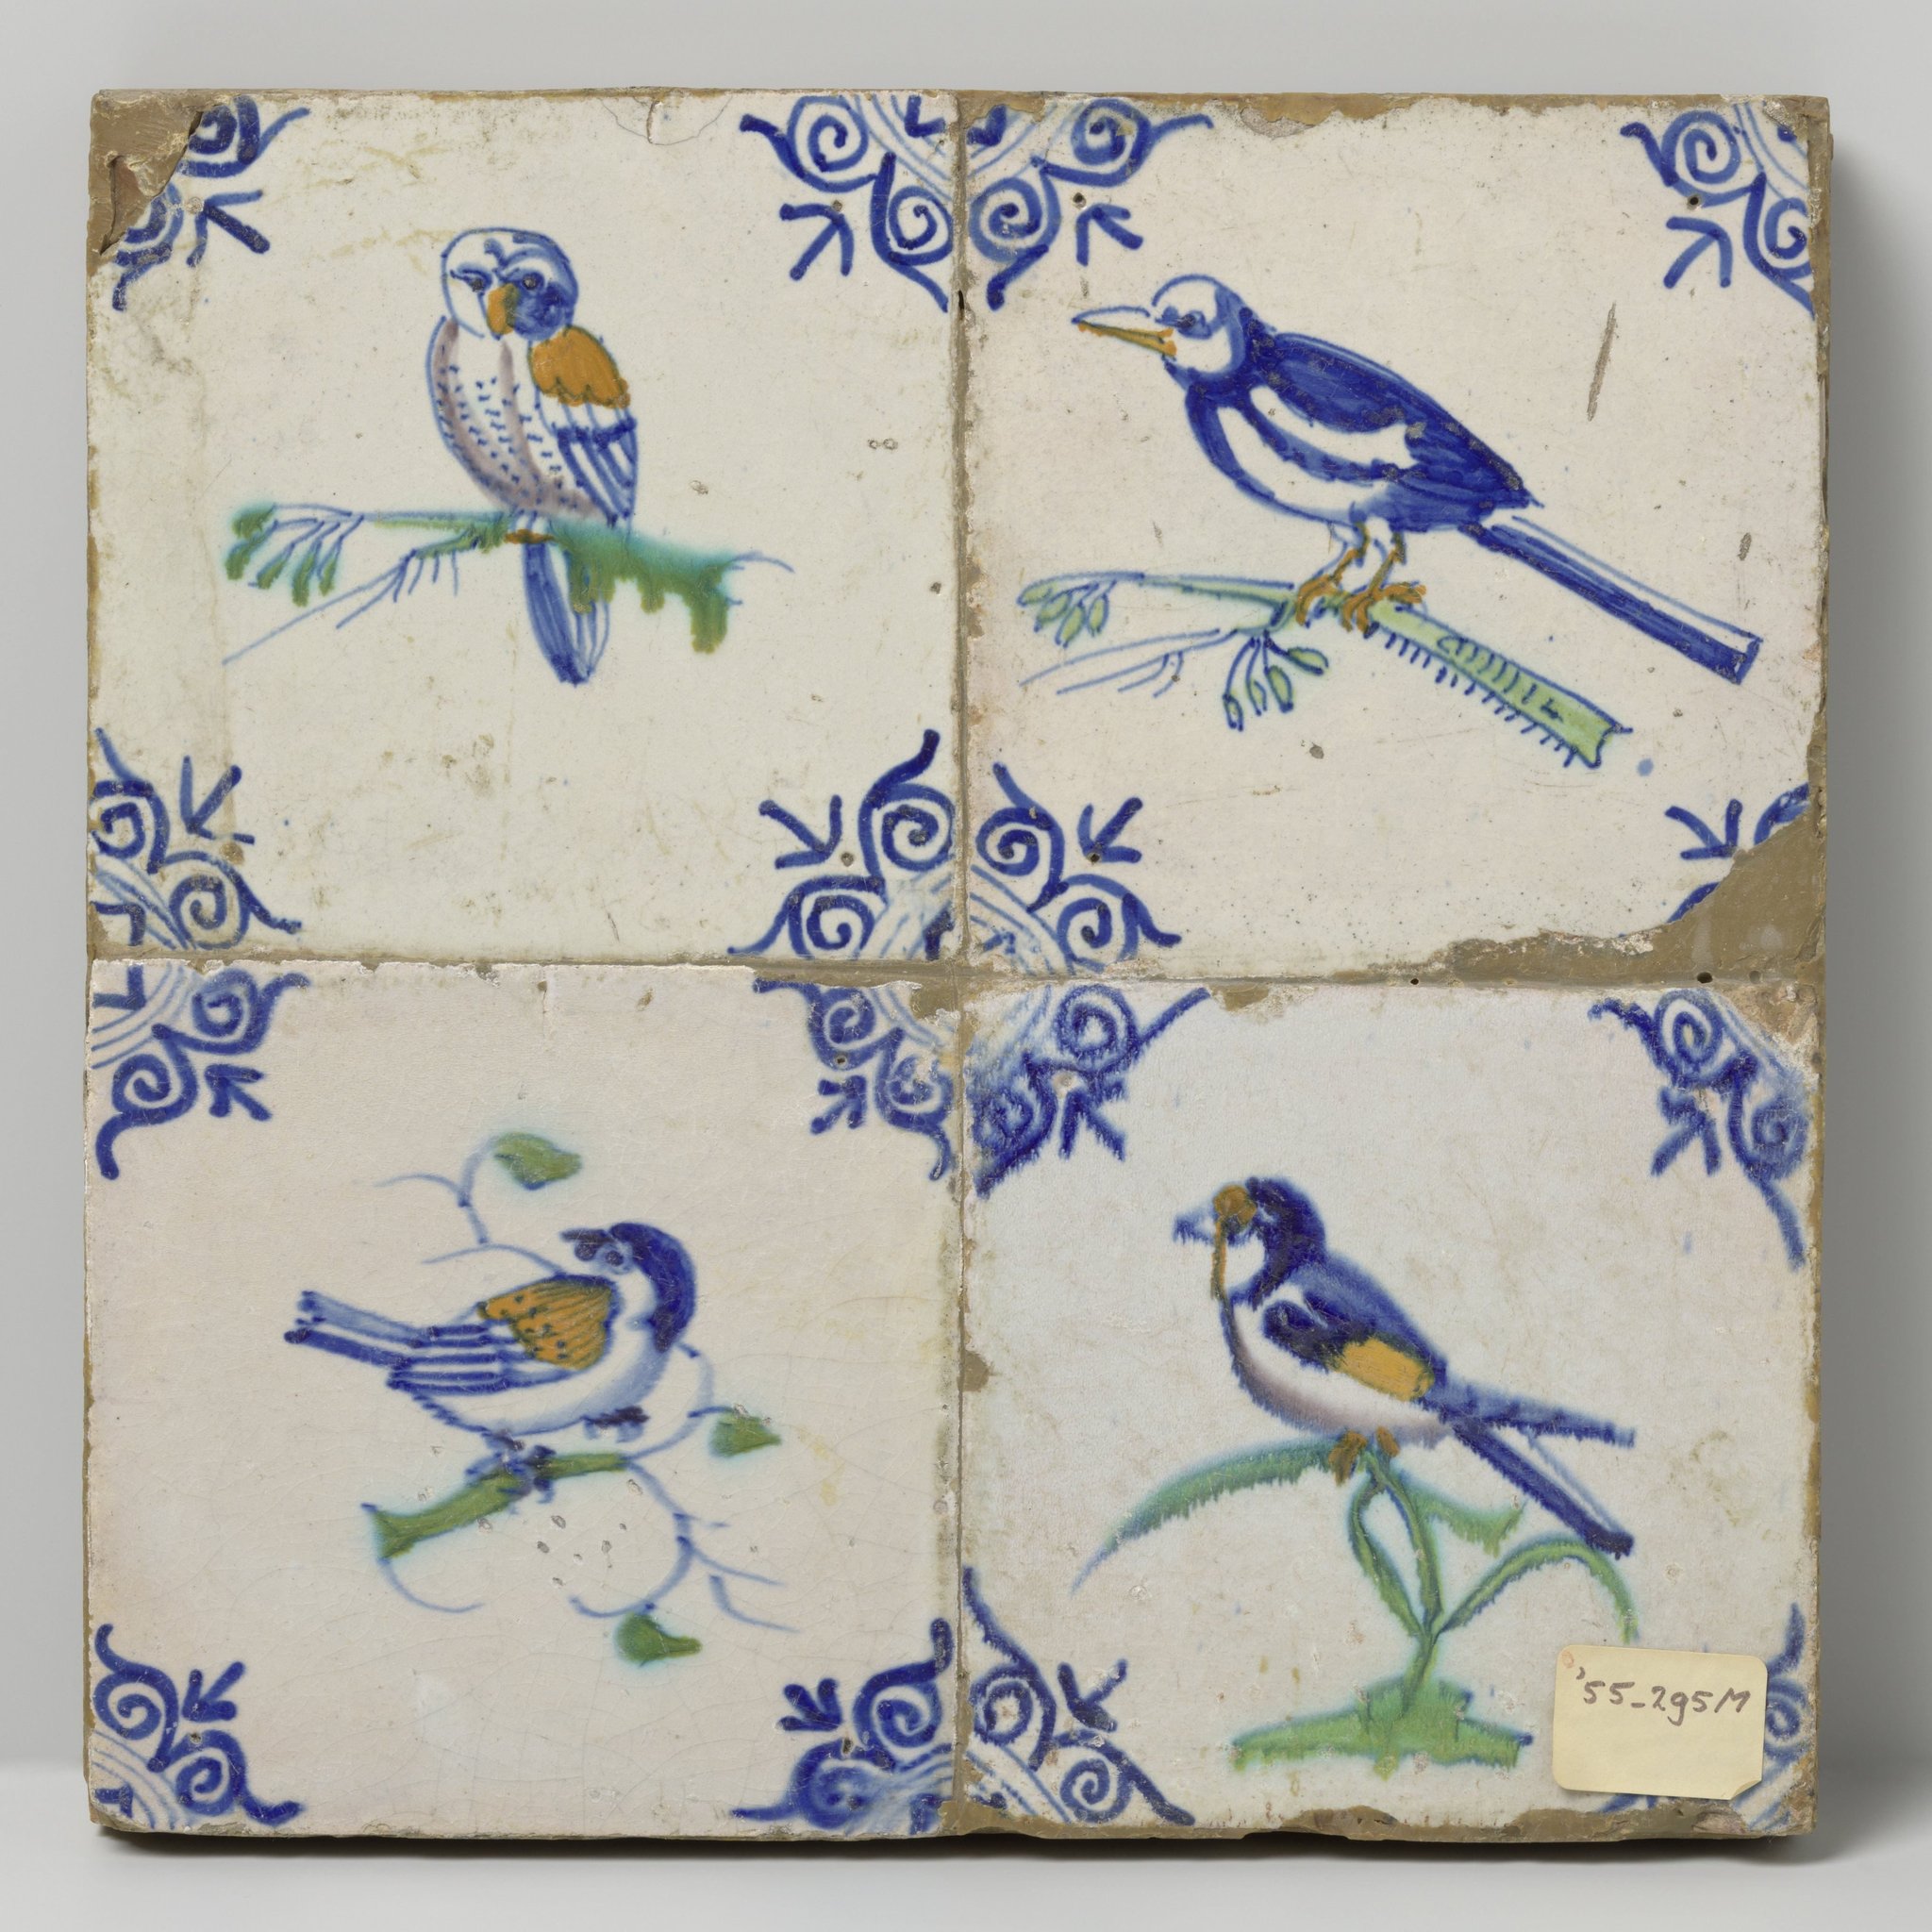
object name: tile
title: Veld van vier tegels met vogels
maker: Anonymous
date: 1640-1660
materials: earthenware, glaze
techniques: maiolica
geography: netherlands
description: Veld van vier tegels (2 x 2) elk met een veelkleurige (blauw, groen, geel, oranje en paars) vogel op een tak. In de hoeken, een ossekop.